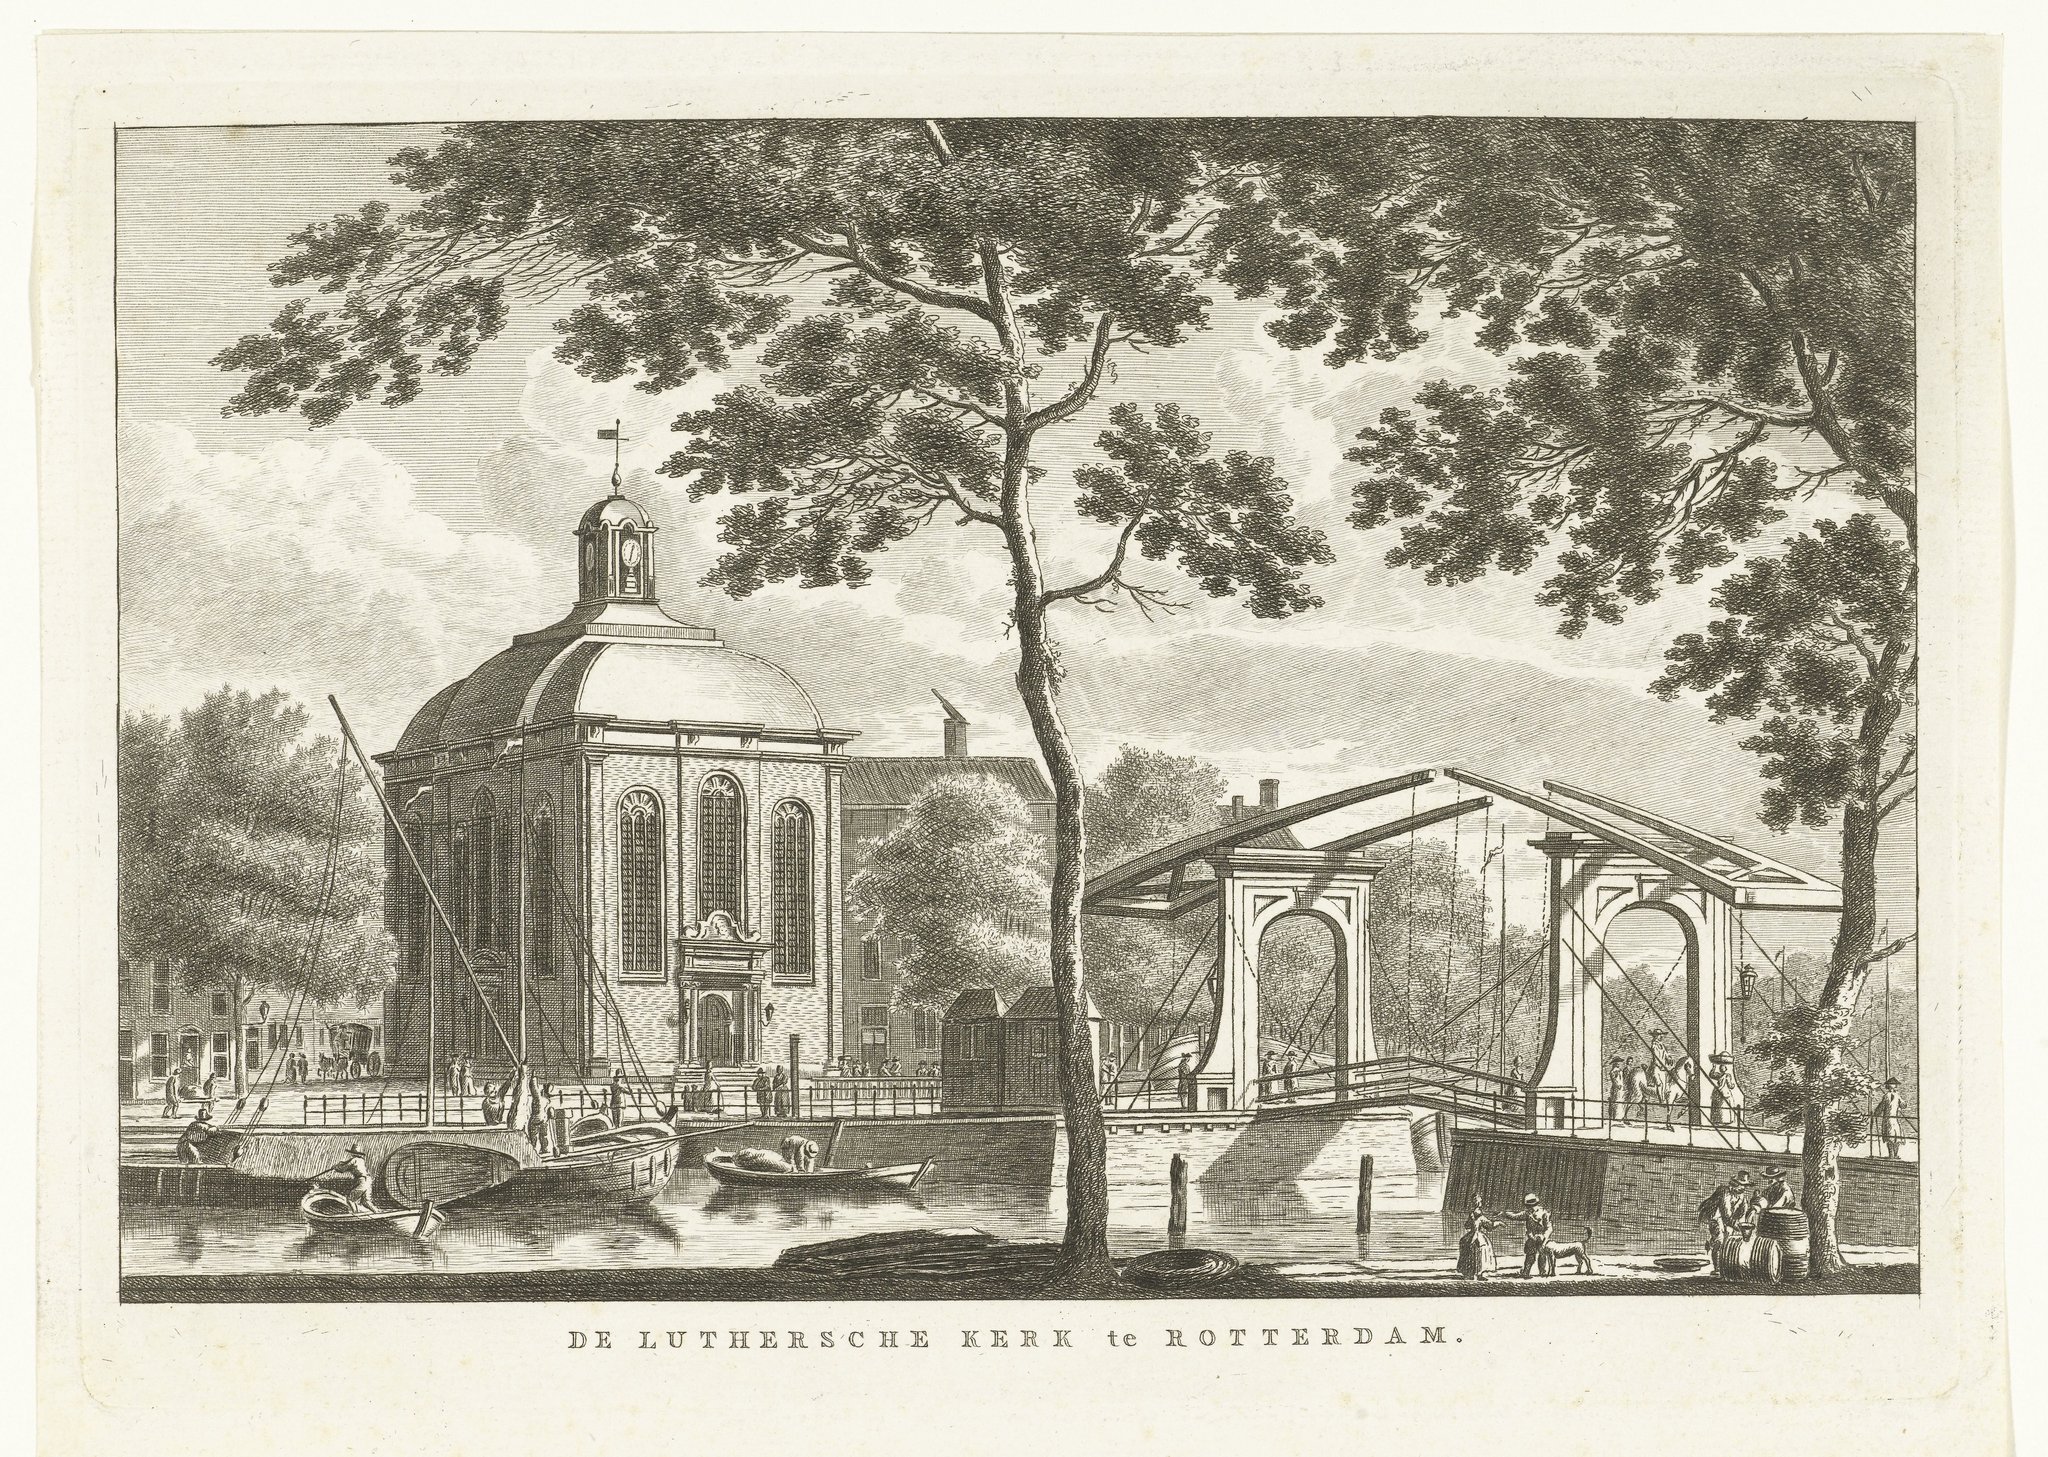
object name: print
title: Stadsgezicht met Lutherse Kerk te Rotterdam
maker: carel frederik bendorp (i)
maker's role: print maker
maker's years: 1736-1814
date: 1786-1792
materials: paper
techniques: etching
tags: church (exterior), rotterdam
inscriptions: collector's mark: Lugt 2233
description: Prent uit: Vaderlandsche gezichten, of afbeeldingen van den tegenwoordigen staat der Vereenigde Nederlanden (…). Amsterdam: Hendrik Gartman, Willem Vermandel en Jan Willem Smit, 1786-1792. Uitgegeven in afleveringen met ieder een eigen bifolium en inhoudsopgave. Alle prenten in deze publicatie zijn gegraveerd door Carel Frederik Bendorp (I) en, in de meeste gevallen, gebaseerd op tekeningen van Jan Bulthuis.